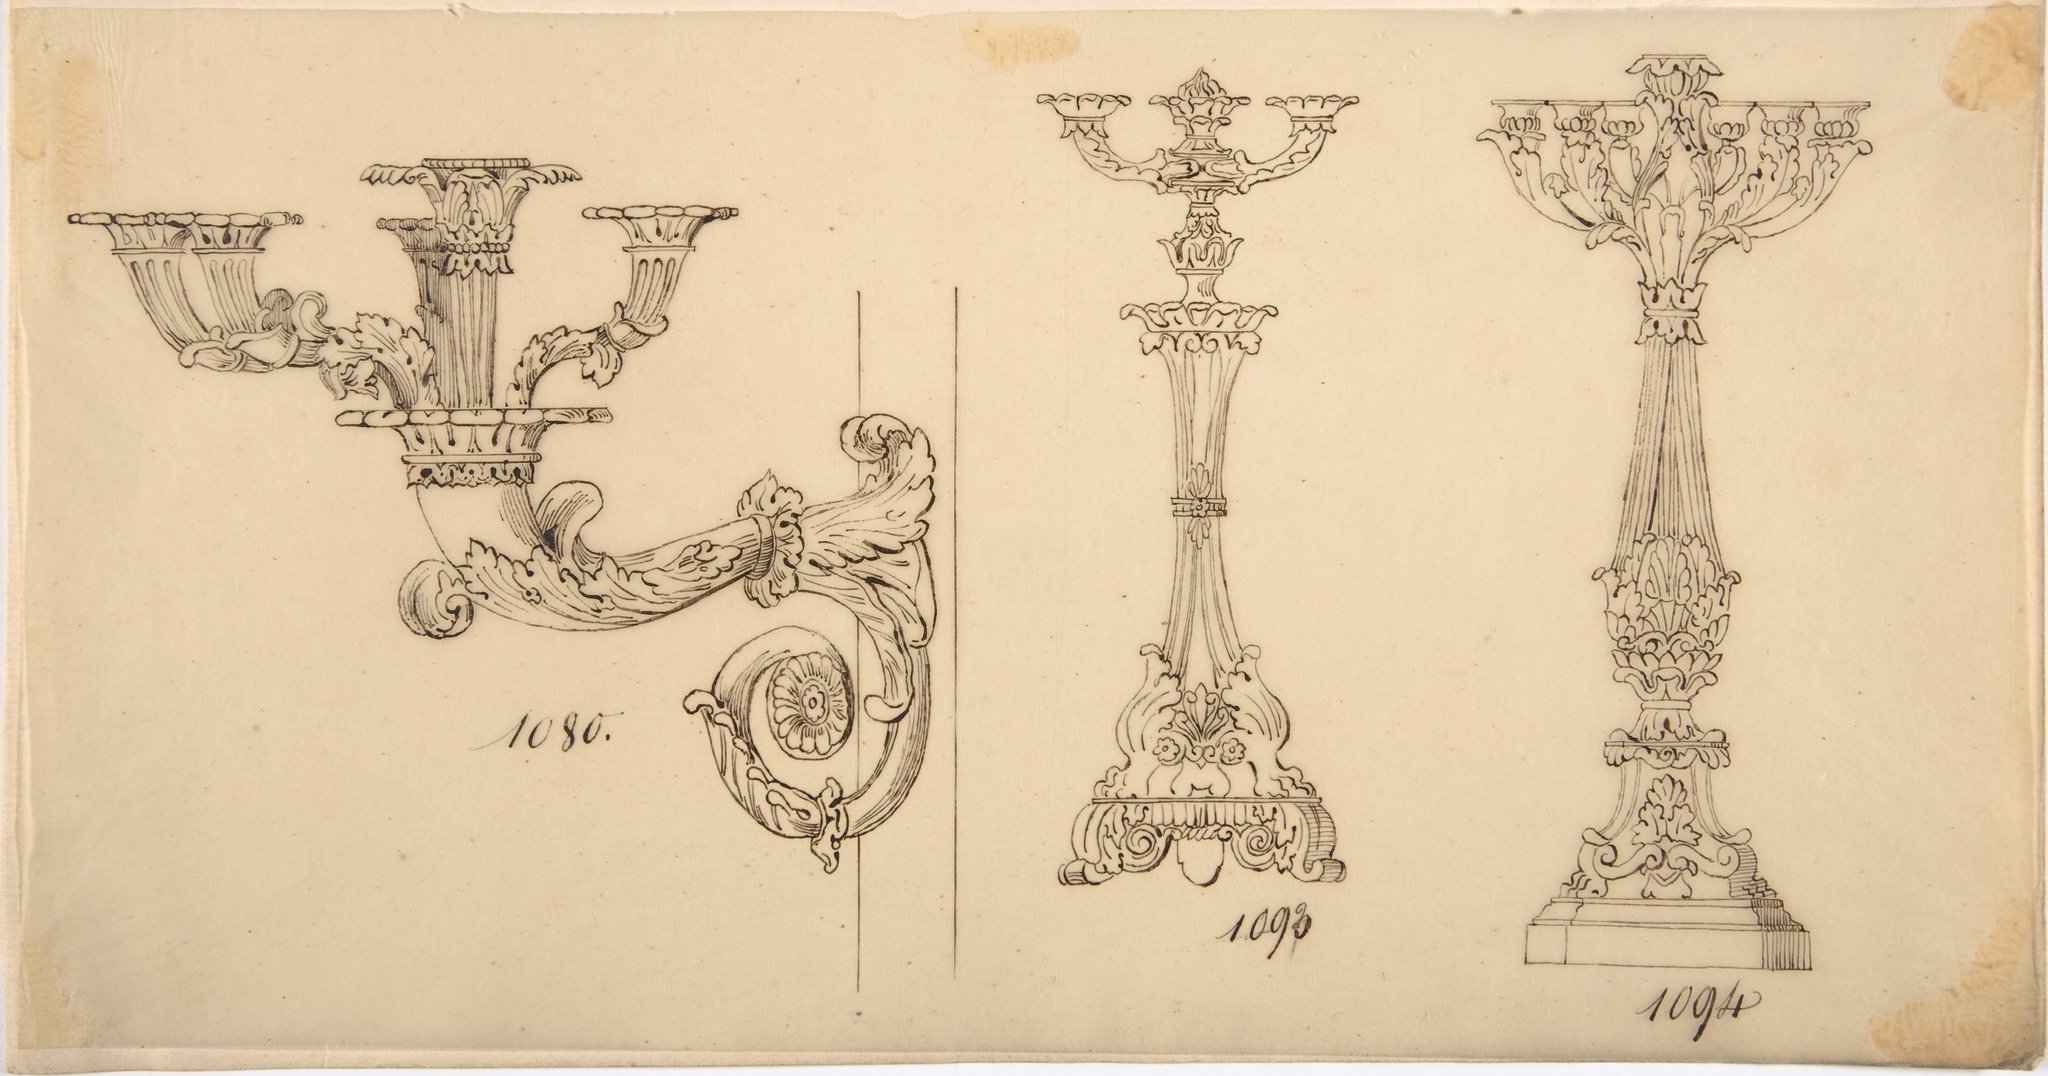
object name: drawing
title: Design for a Sconce and Two Candelabras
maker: anonymous, french, 19th century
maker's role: artist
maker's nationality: french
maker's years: 1800-1900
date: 1801-1900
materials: ink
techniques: pen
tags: candelabra